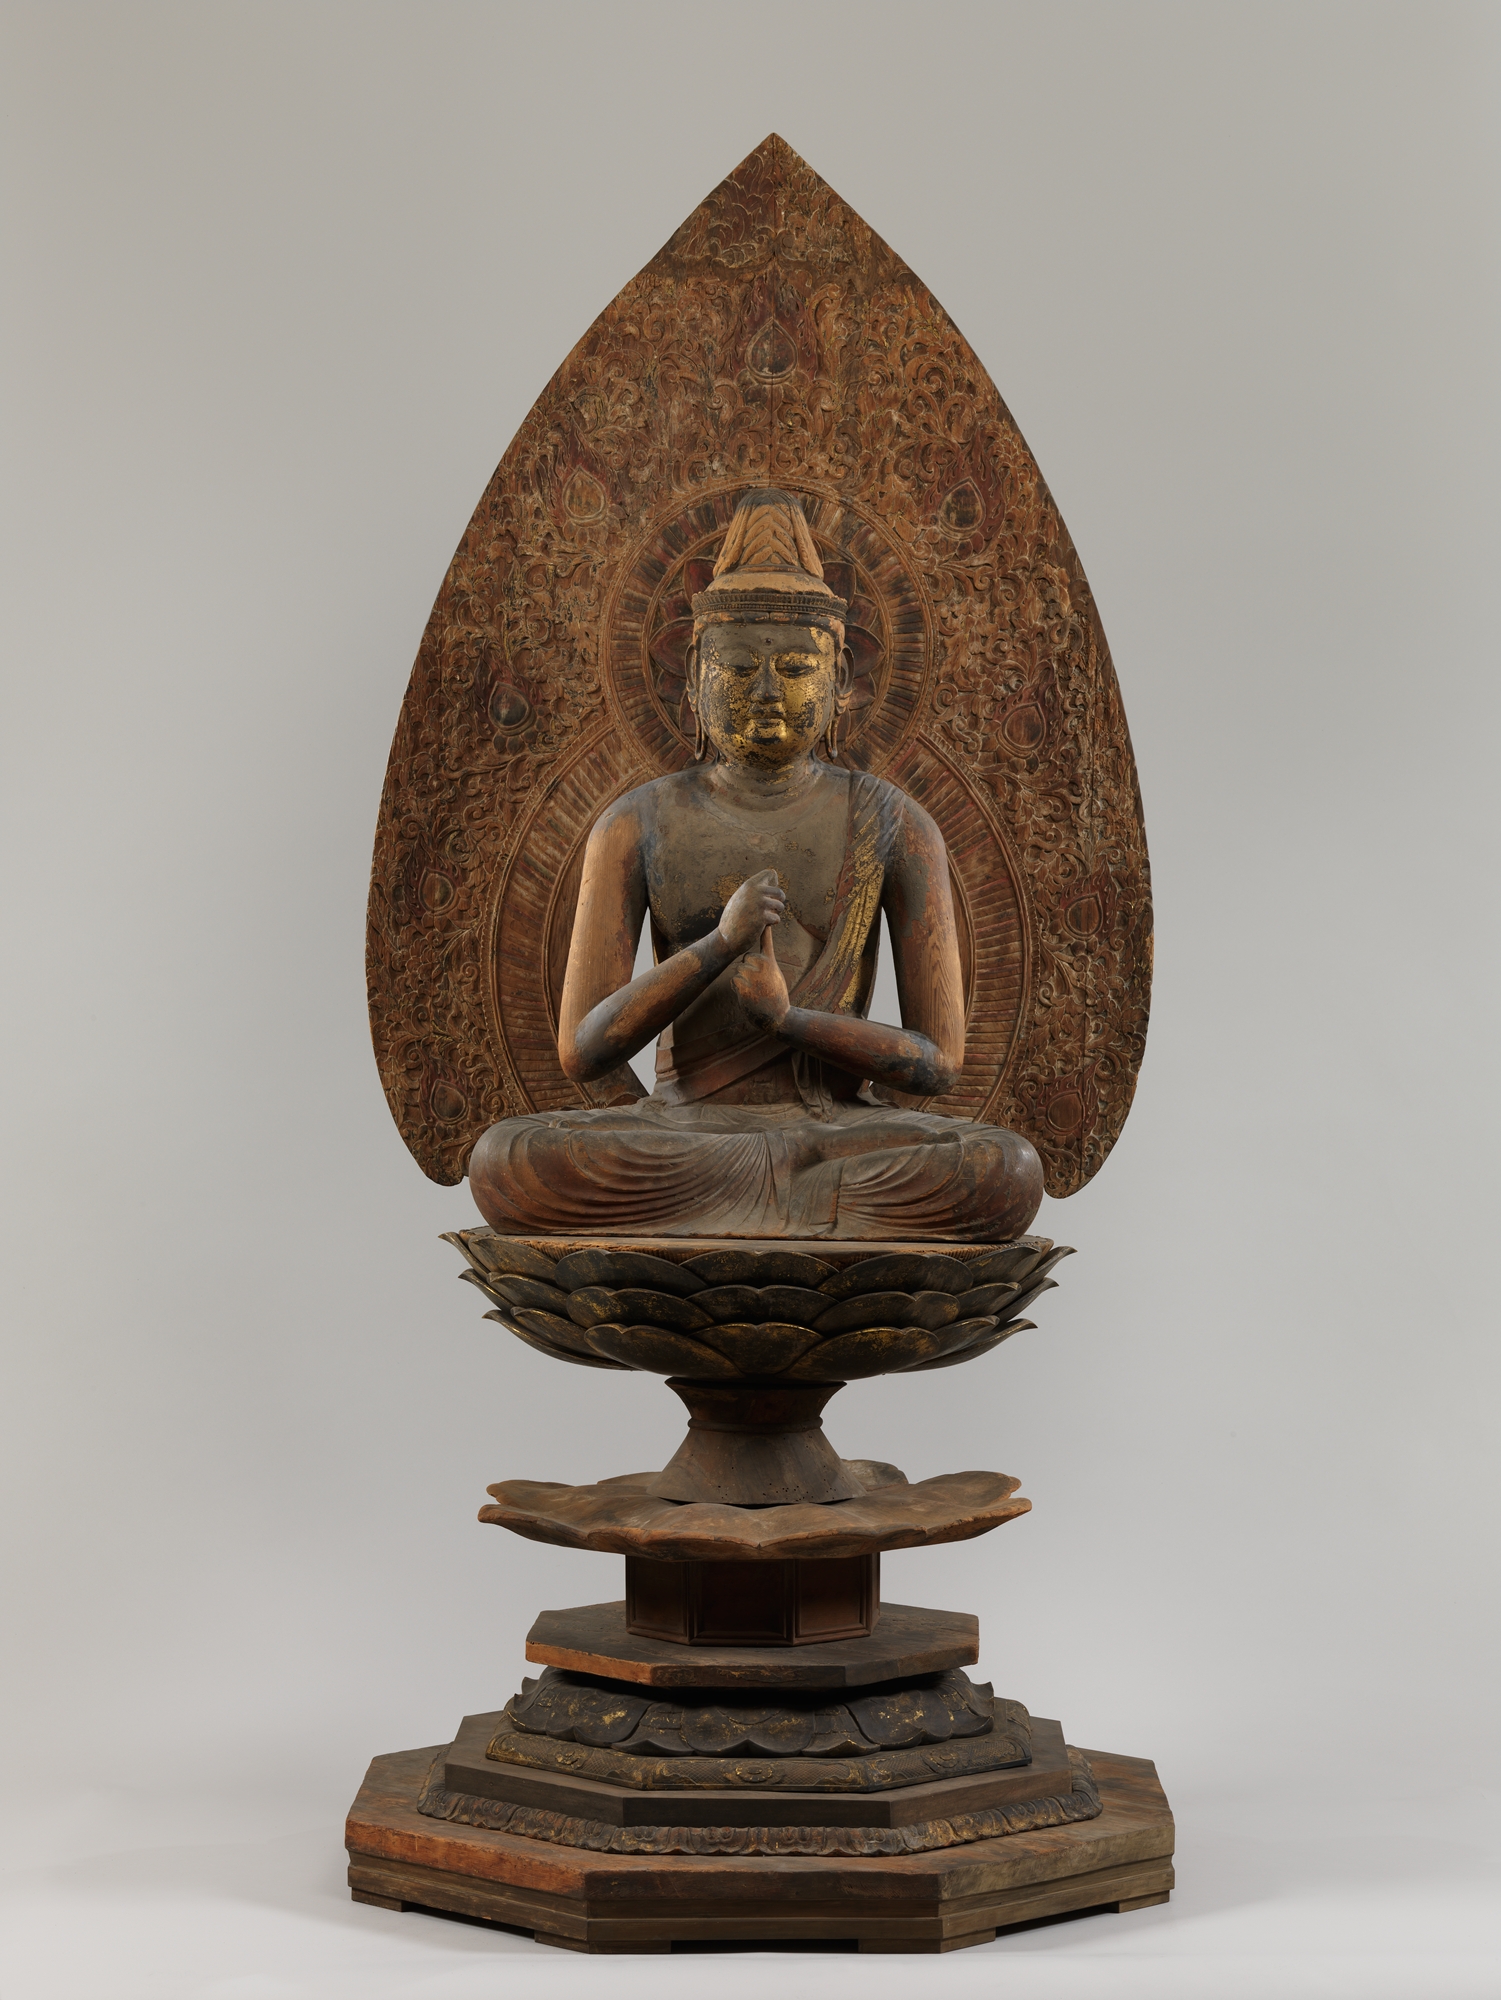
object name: statue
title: Dainichi, the Cosmic Buddha (Mahavairocana)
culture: japanese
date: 1101-1200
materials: gold leaf, lacquer, wood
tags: buddhism,buddha